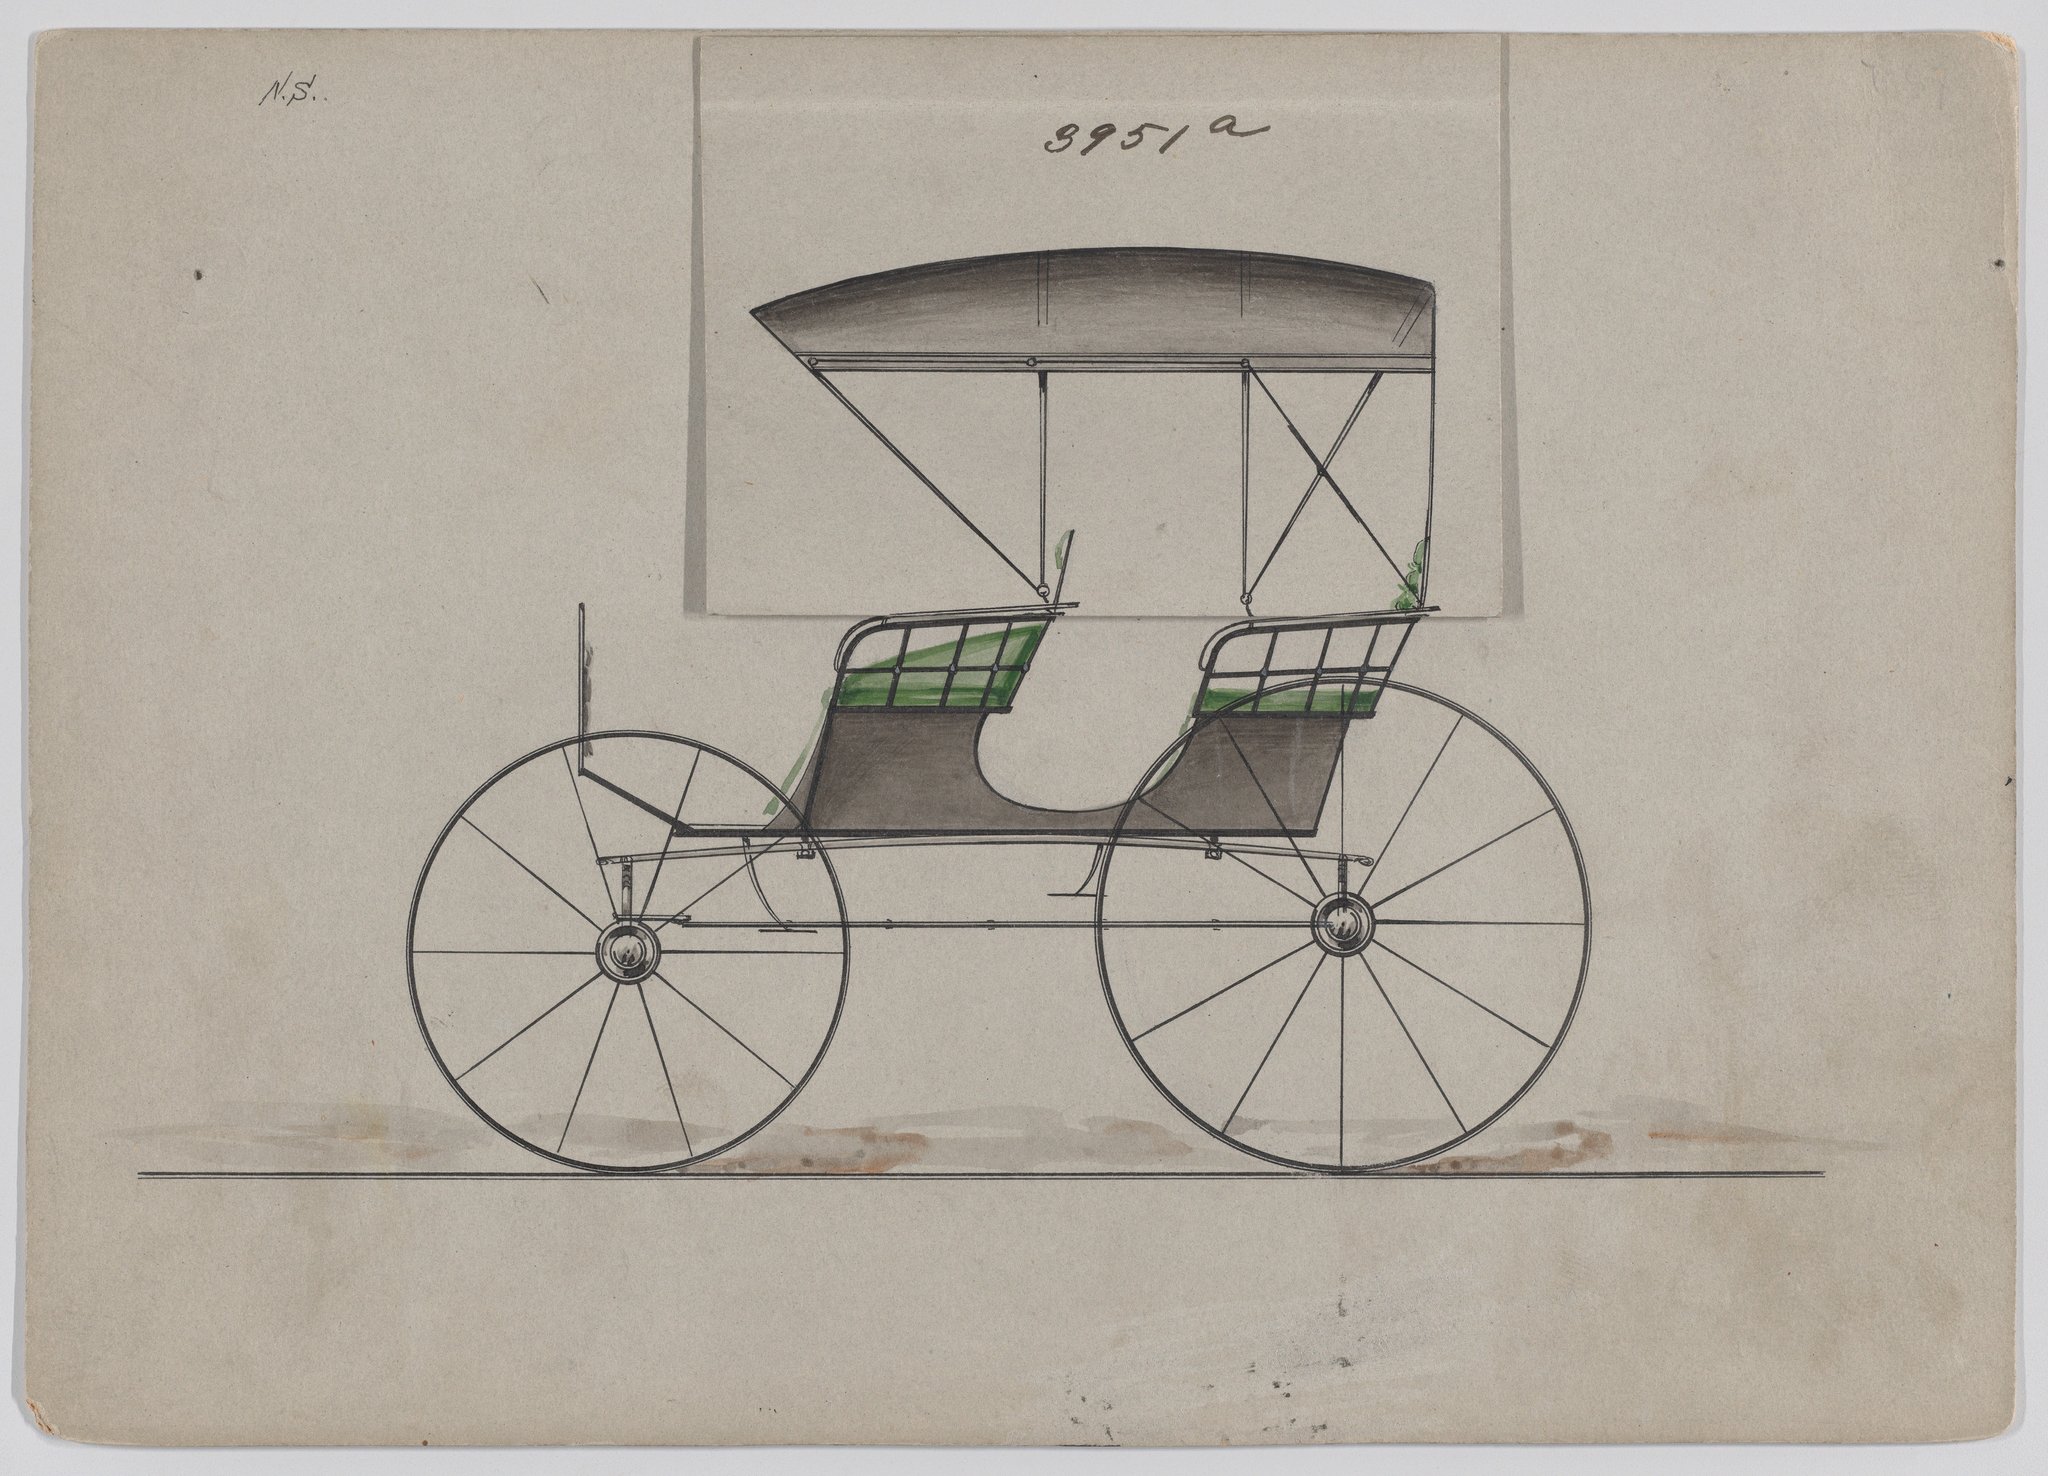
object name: drawing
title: Design for Park Phaeton, no. 3951a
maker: brewster & co.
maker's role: manufacturer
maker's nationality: american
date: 1885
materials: gouache, ink, watercolor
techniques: pen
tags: carriages